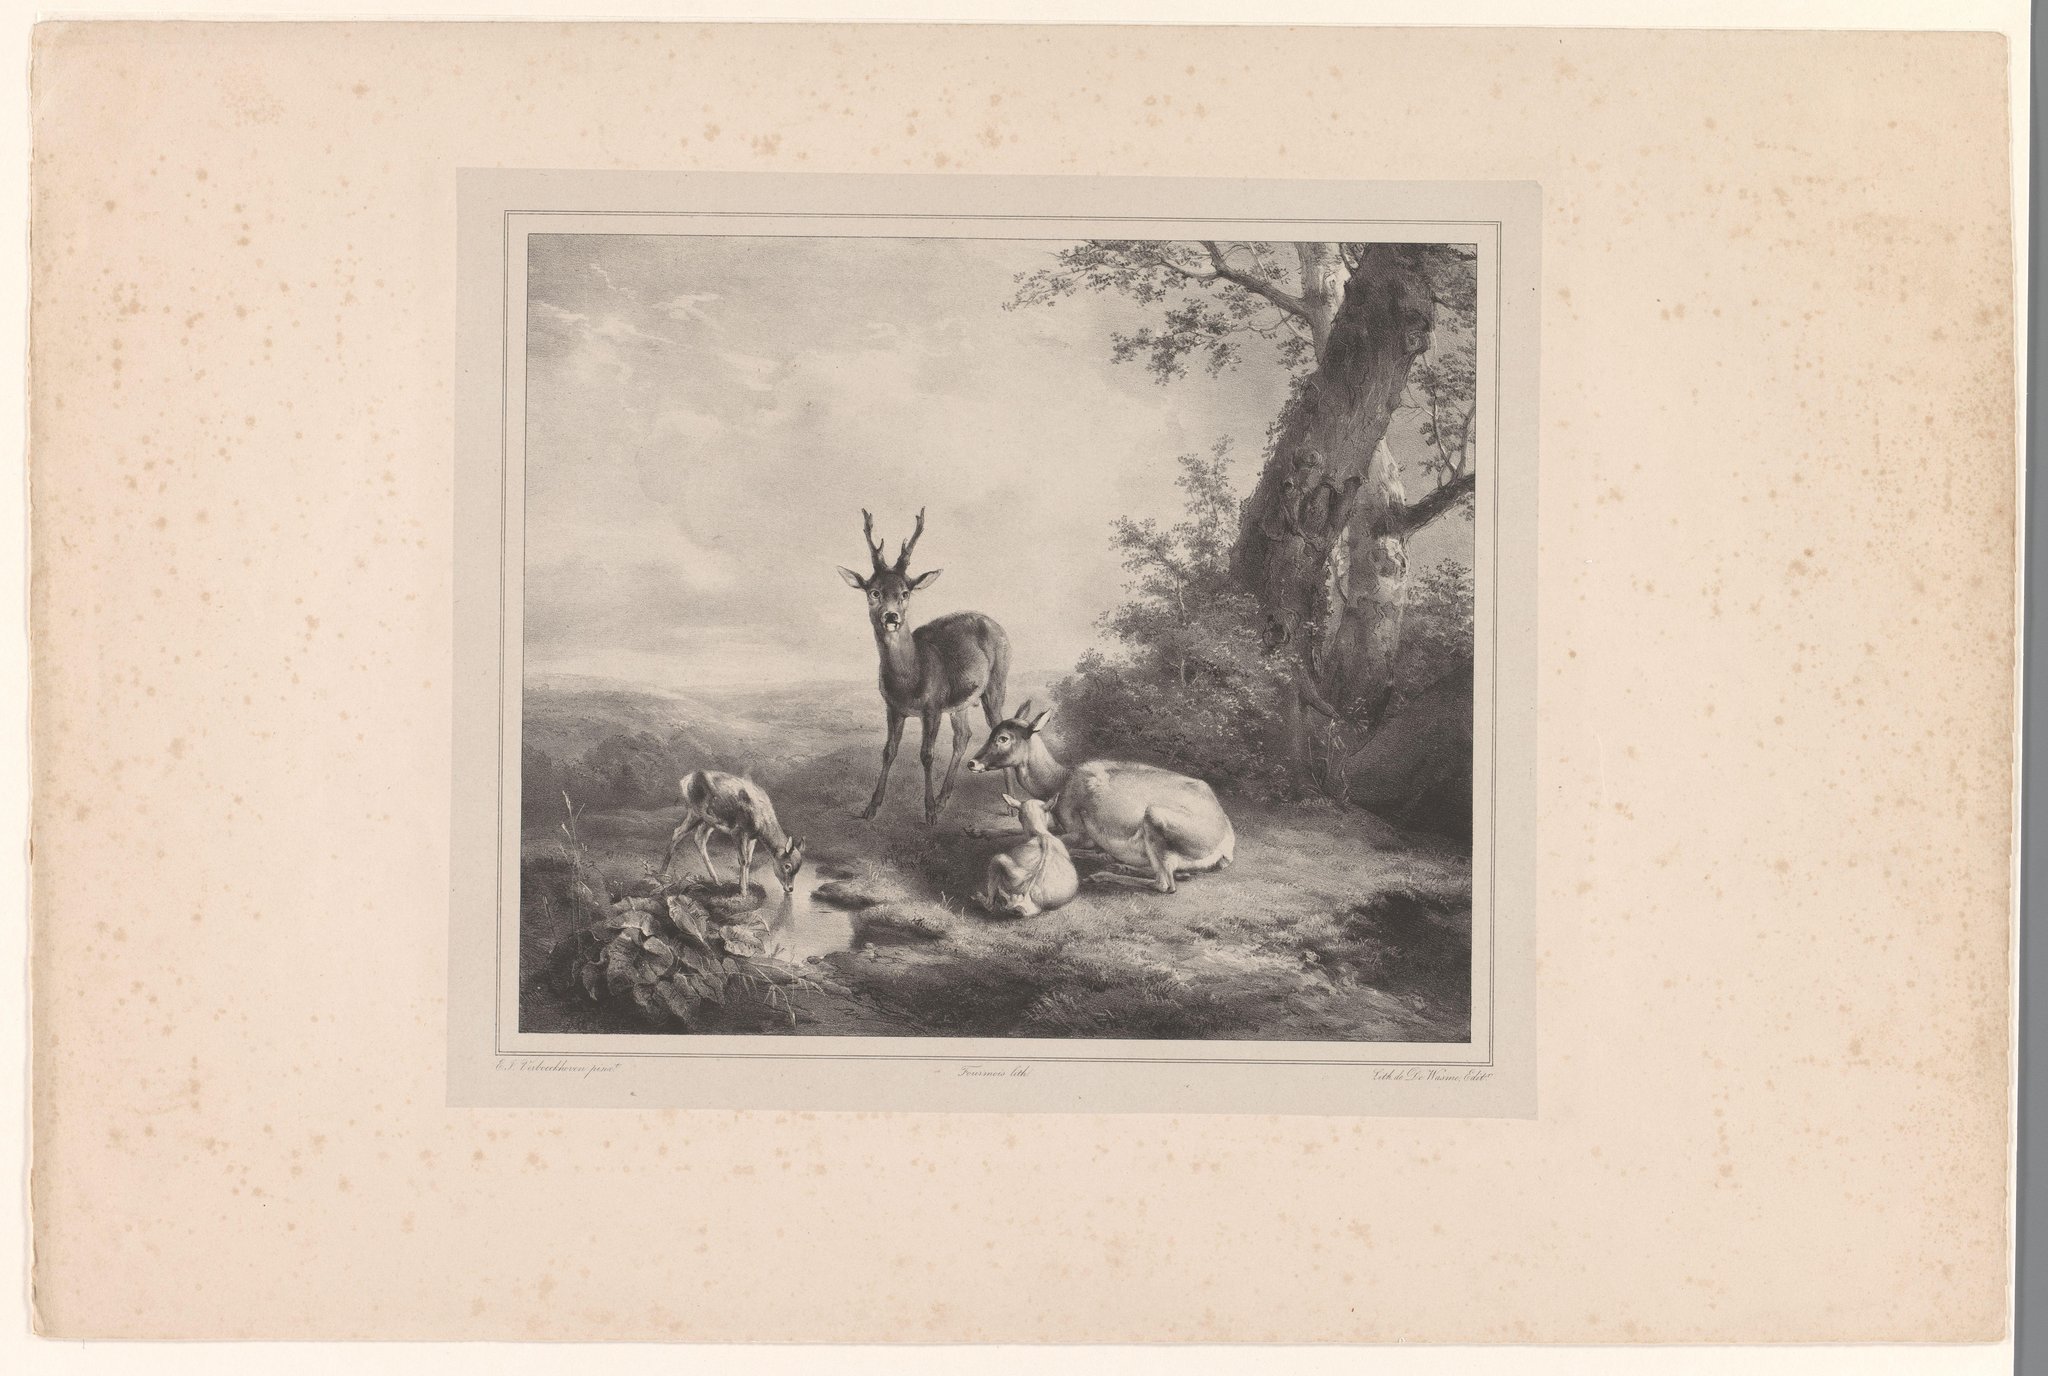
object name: print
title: Zes landschappen met dieren door Théodore Fourmois naar schilderijen van Eugène Verboeckhoven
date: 1835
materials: paper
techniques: lithograph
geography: brussels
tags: low hill country, hoofed animals: deer, brook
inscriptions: collector's mark: Lugt 2228